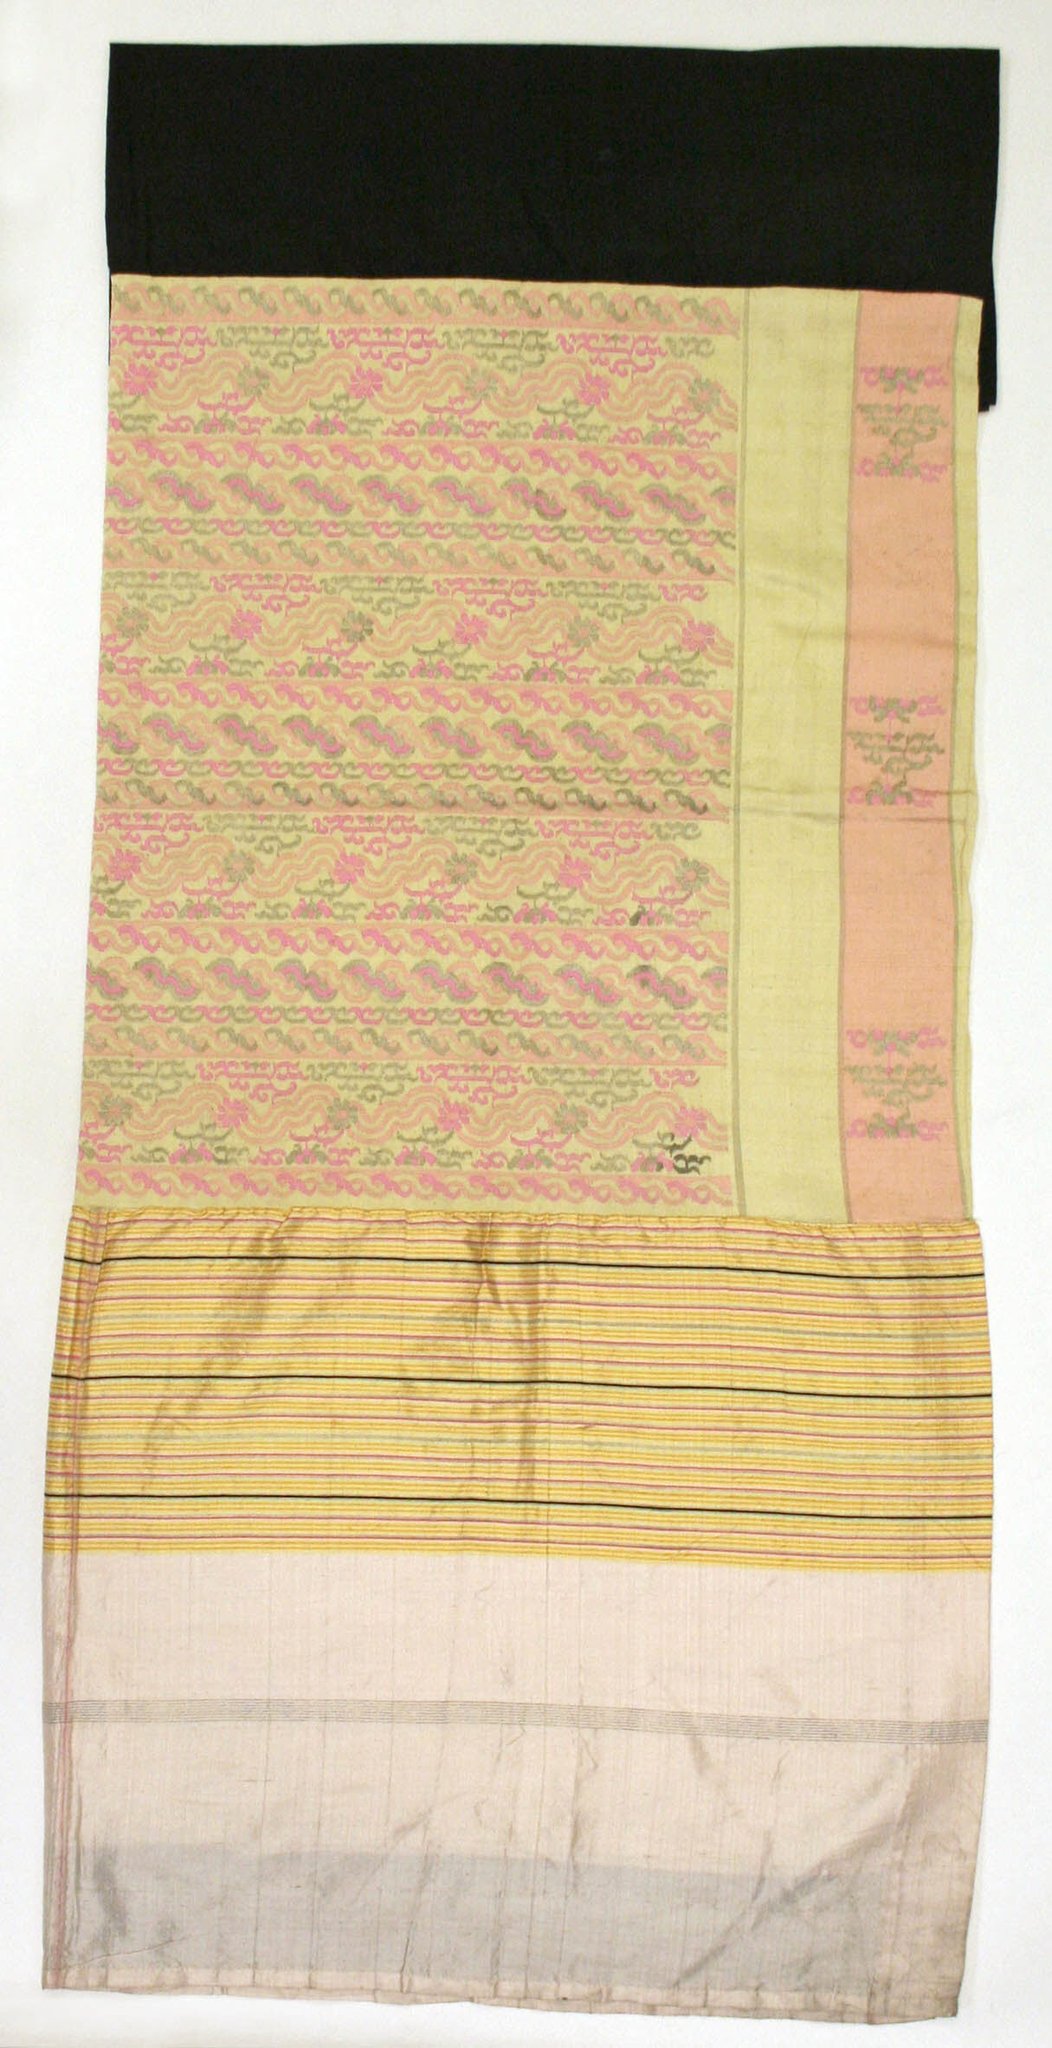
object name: sarong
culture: burmese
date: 1801-1900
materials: silk